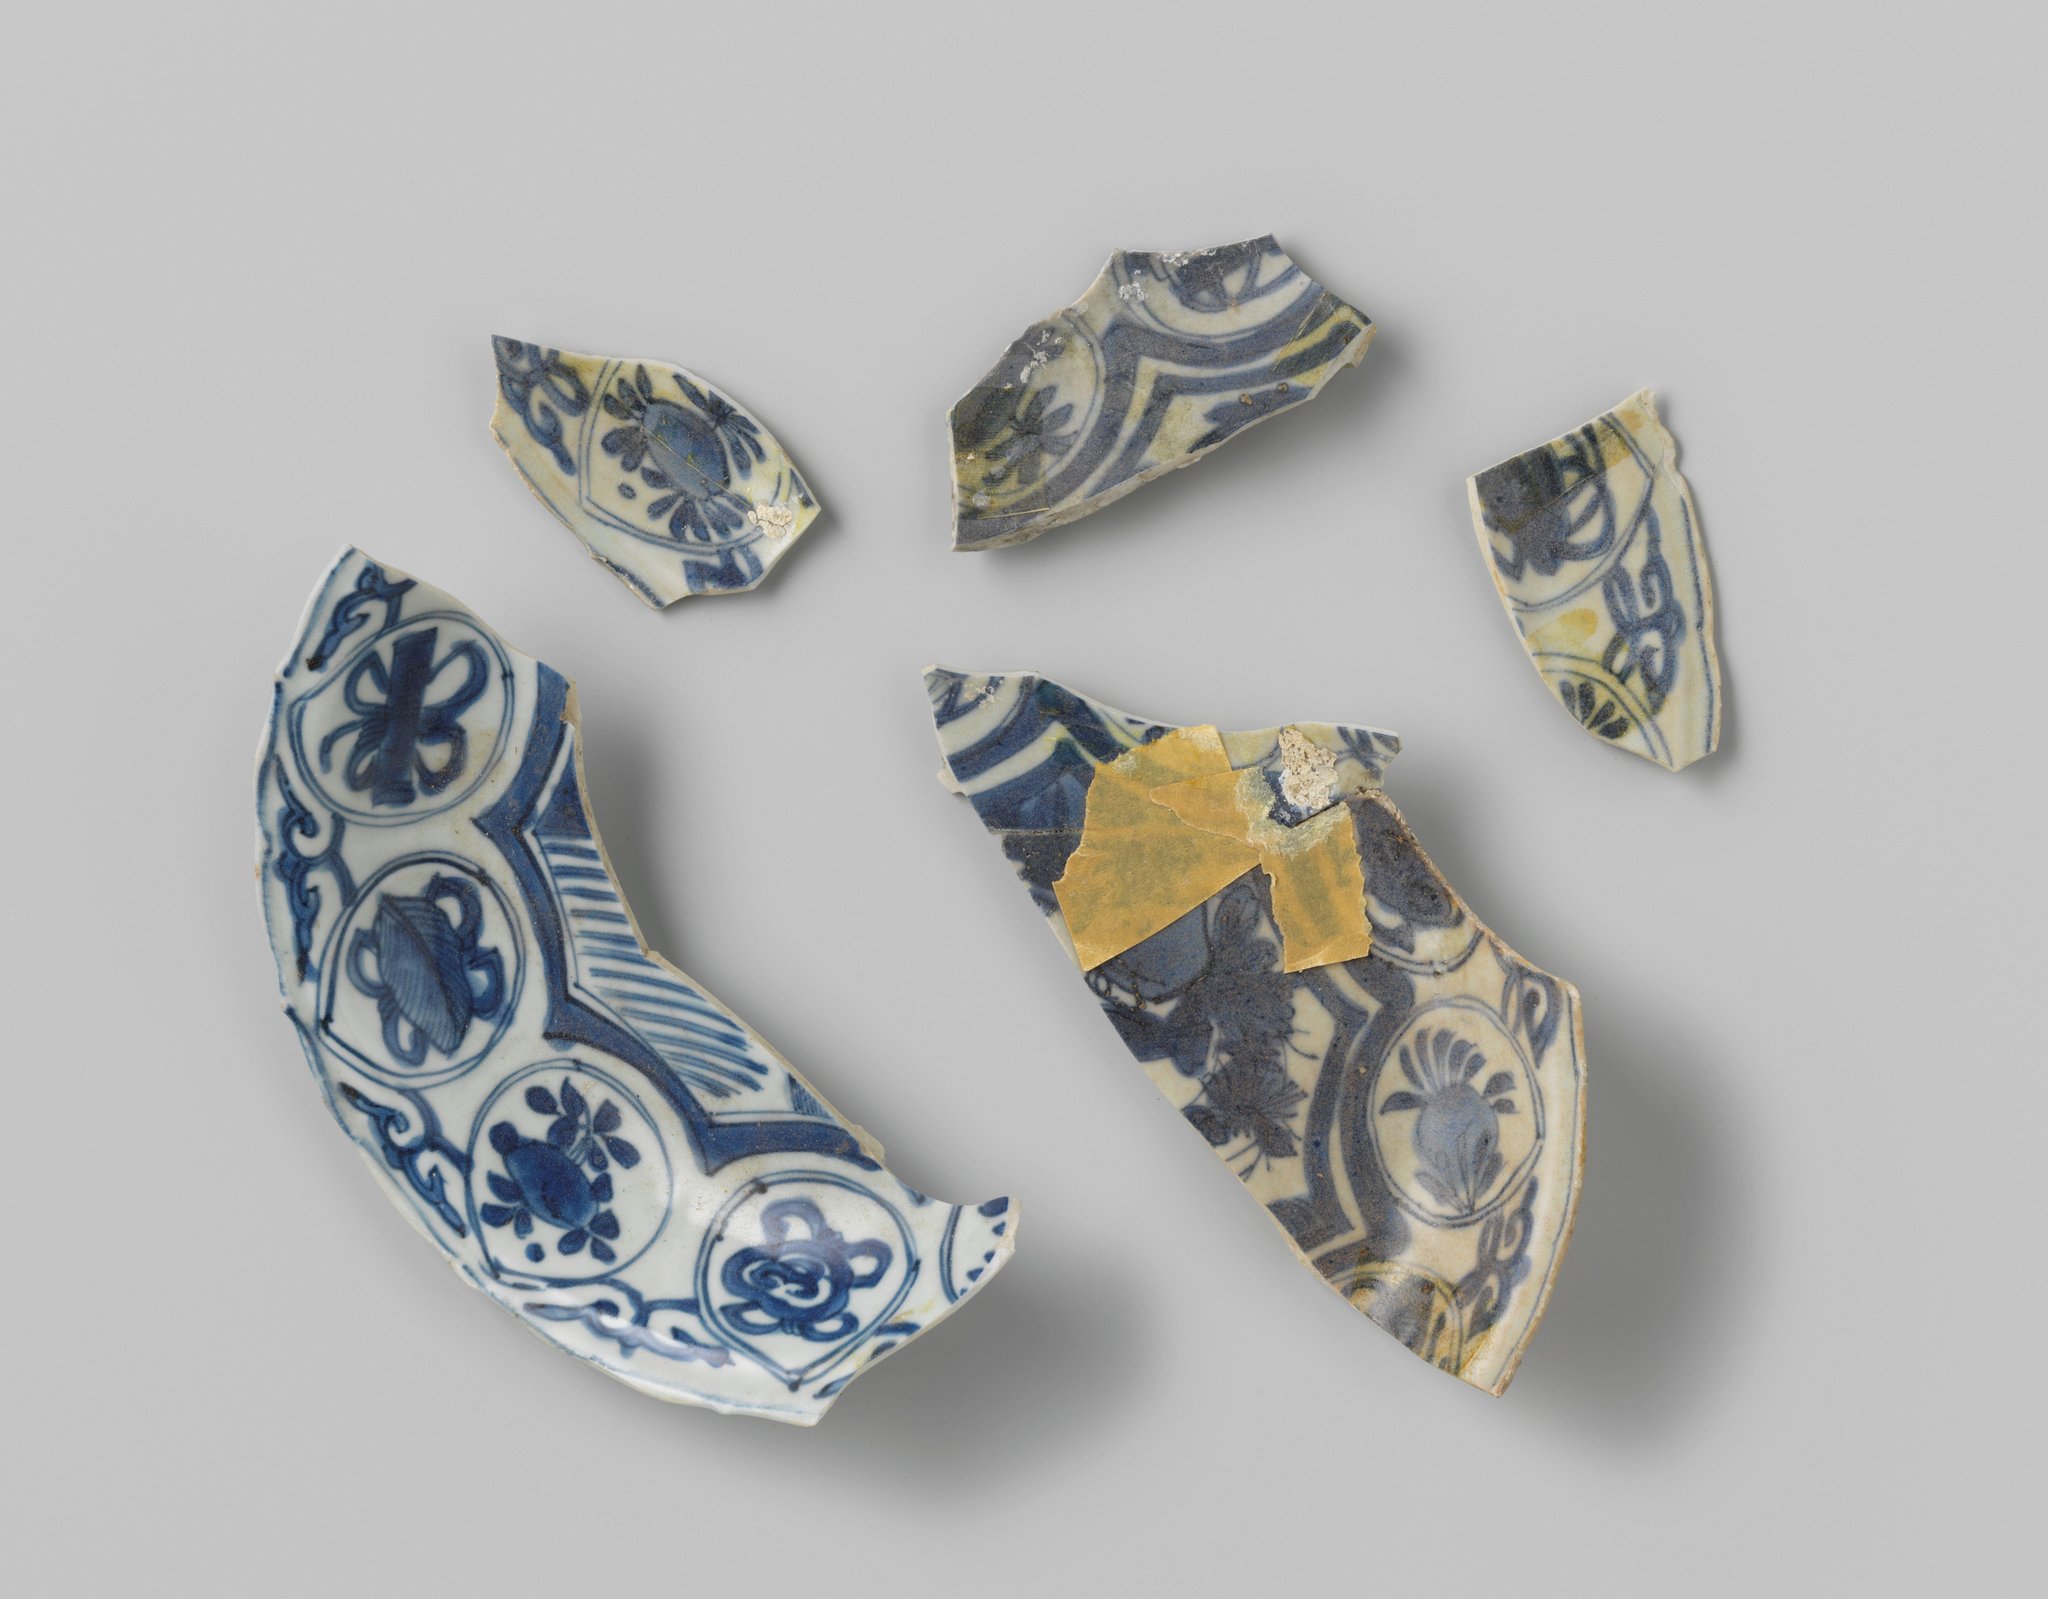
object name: plate dish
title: Scherven van kraakporseleinen borden uit V.O.C.-schip de 'Witte Leeuw'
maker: Anonymous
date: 1613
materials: bone china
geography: jingdezhen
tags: verenigde oostindische compagnie, sint-helena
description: Scherven van kraakporseleinen borden uit V.O.C.-schip de 'Witte Leeuw'.